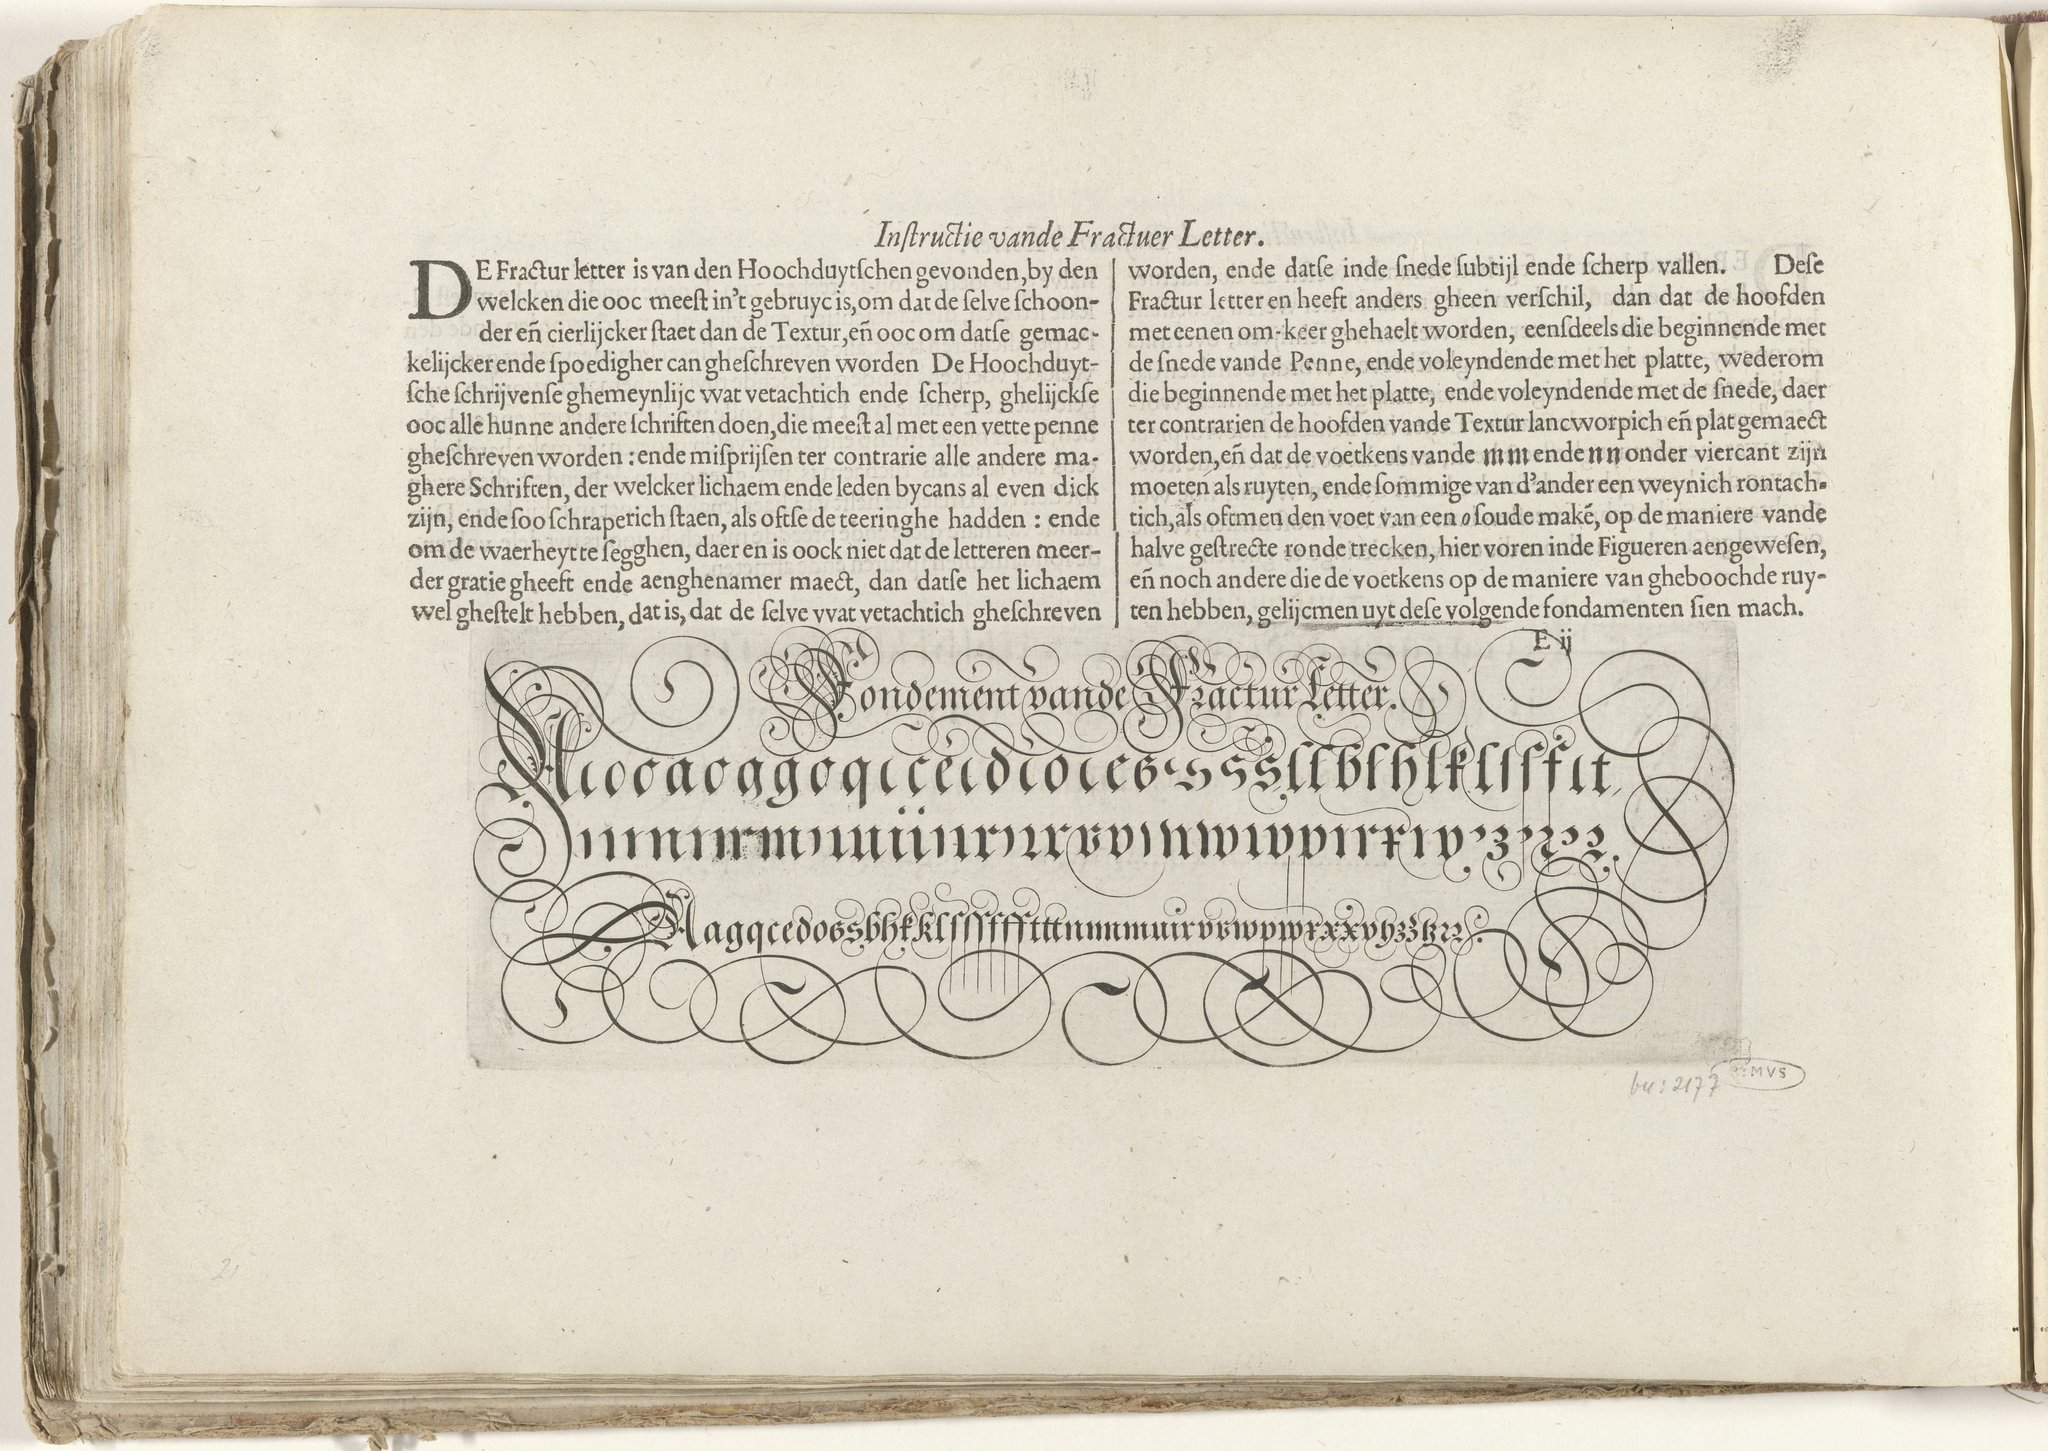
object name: print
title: Spieghel der schrijfkonste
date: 1605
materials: paper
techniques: engraving, letterpress printing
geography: amsterdam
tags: calligraphy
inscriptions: collector's mark: Lugt 2760, collector's mark: Lugt 2228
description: Folio E2r met een beschrijving en een schrijfvoorbeeld van de Fraktuer Letter, getiteld: Fondement vande Fractur Letter. Het blad maakt deel uit van een album.